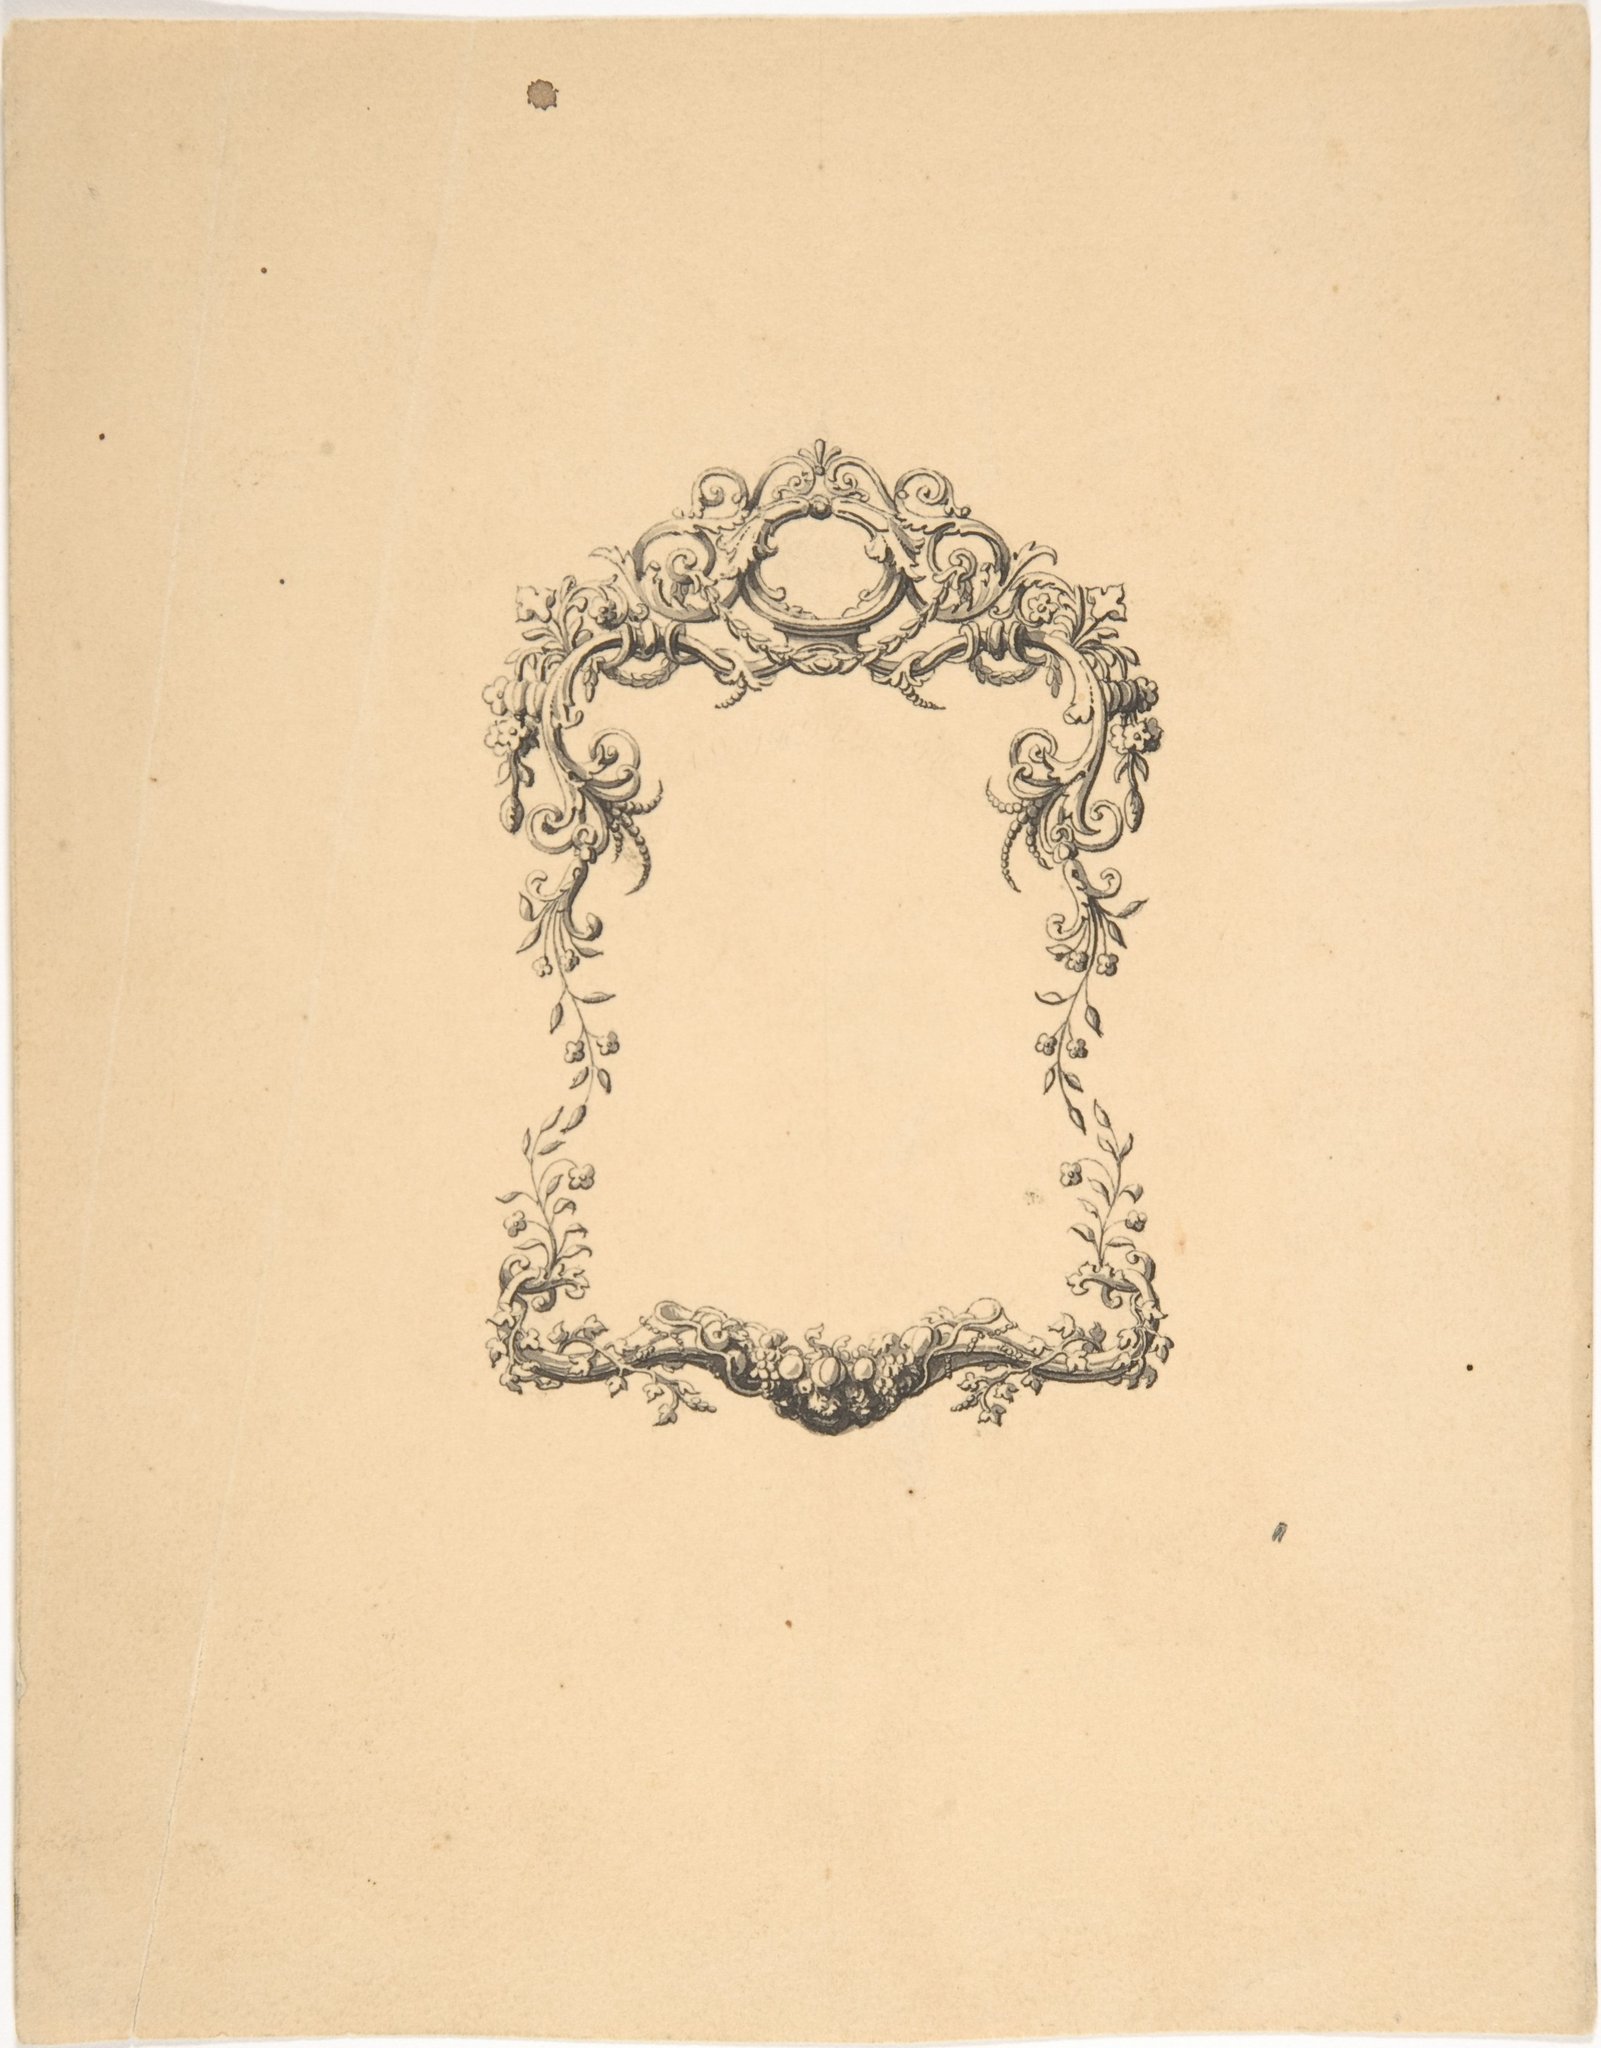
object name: drawing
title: Design for Frame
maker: robert william hume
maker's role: artist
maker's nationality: british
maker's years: 1816-1904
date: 1830-1900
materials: ink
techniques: brush, pen, wash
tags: flowers,leaves